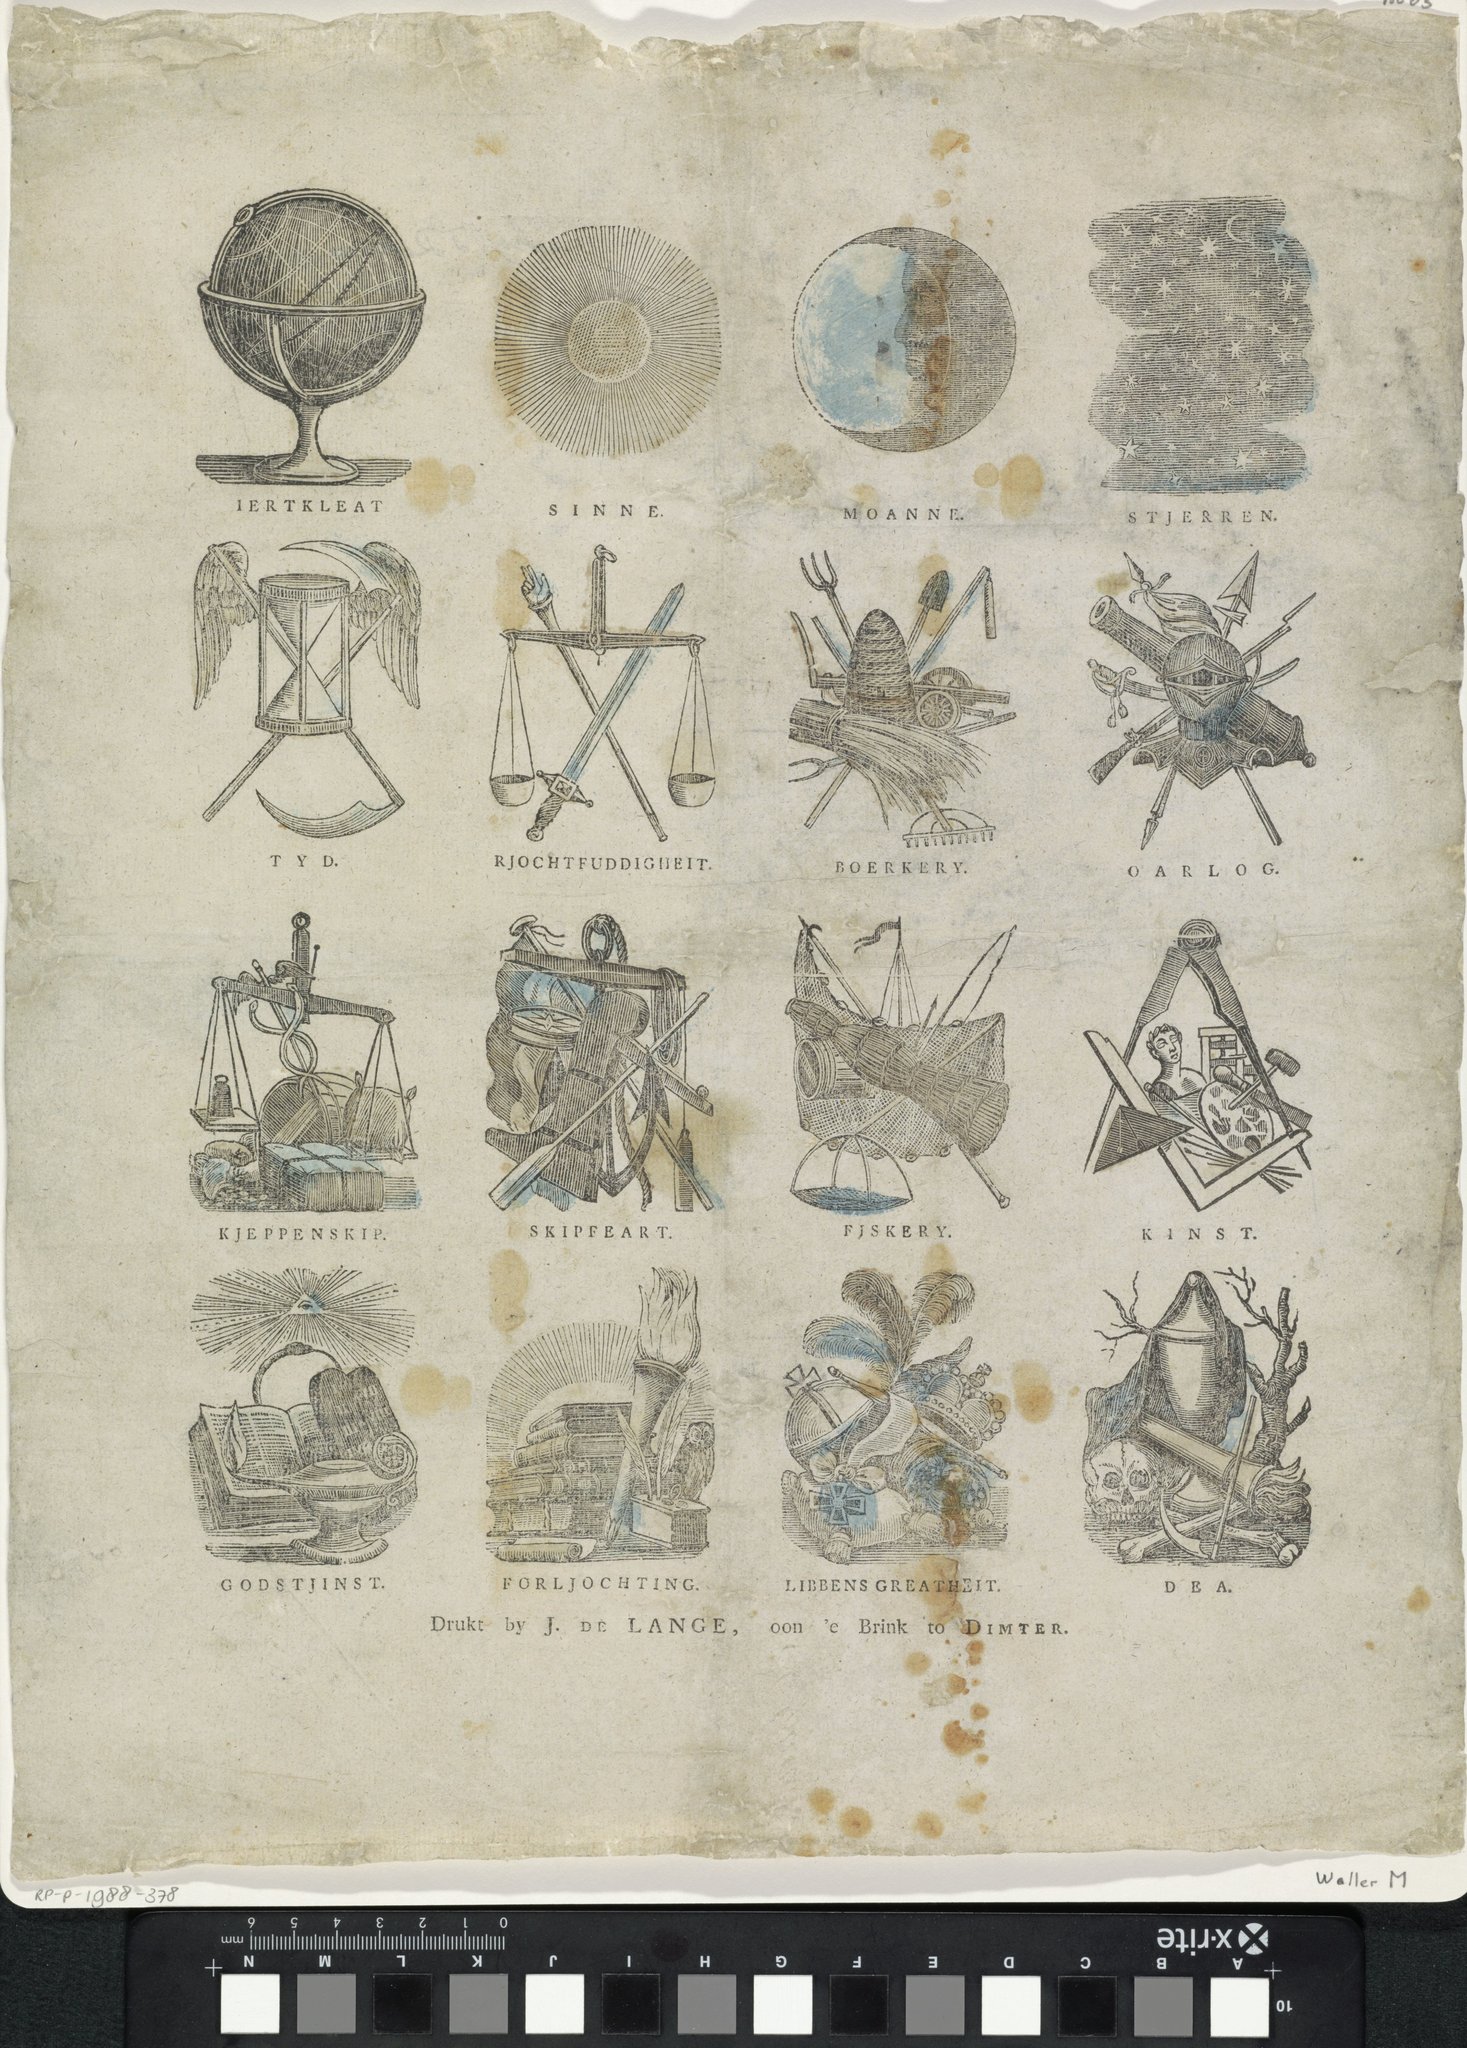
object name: print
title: Verschillende zaken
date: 1822-1849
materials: paper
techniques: colour, letterpress printing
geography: netherlands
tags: sun as celestial body, symbolic representations, allegories and emblems ~ art; 'arte' (ripa), waning moon represented as face, allegory of time and eternity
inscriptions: collector's mark: Lugt 2228, collector's mark: Lugt 2760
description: Blad met 16 voorstellingen van verschillende aard, zoals voorstellingen van de zon en de maan en allegorische voorstellingen van de tijd en de visserij. Onder elke afbeelding een onderschrift in het Fries.